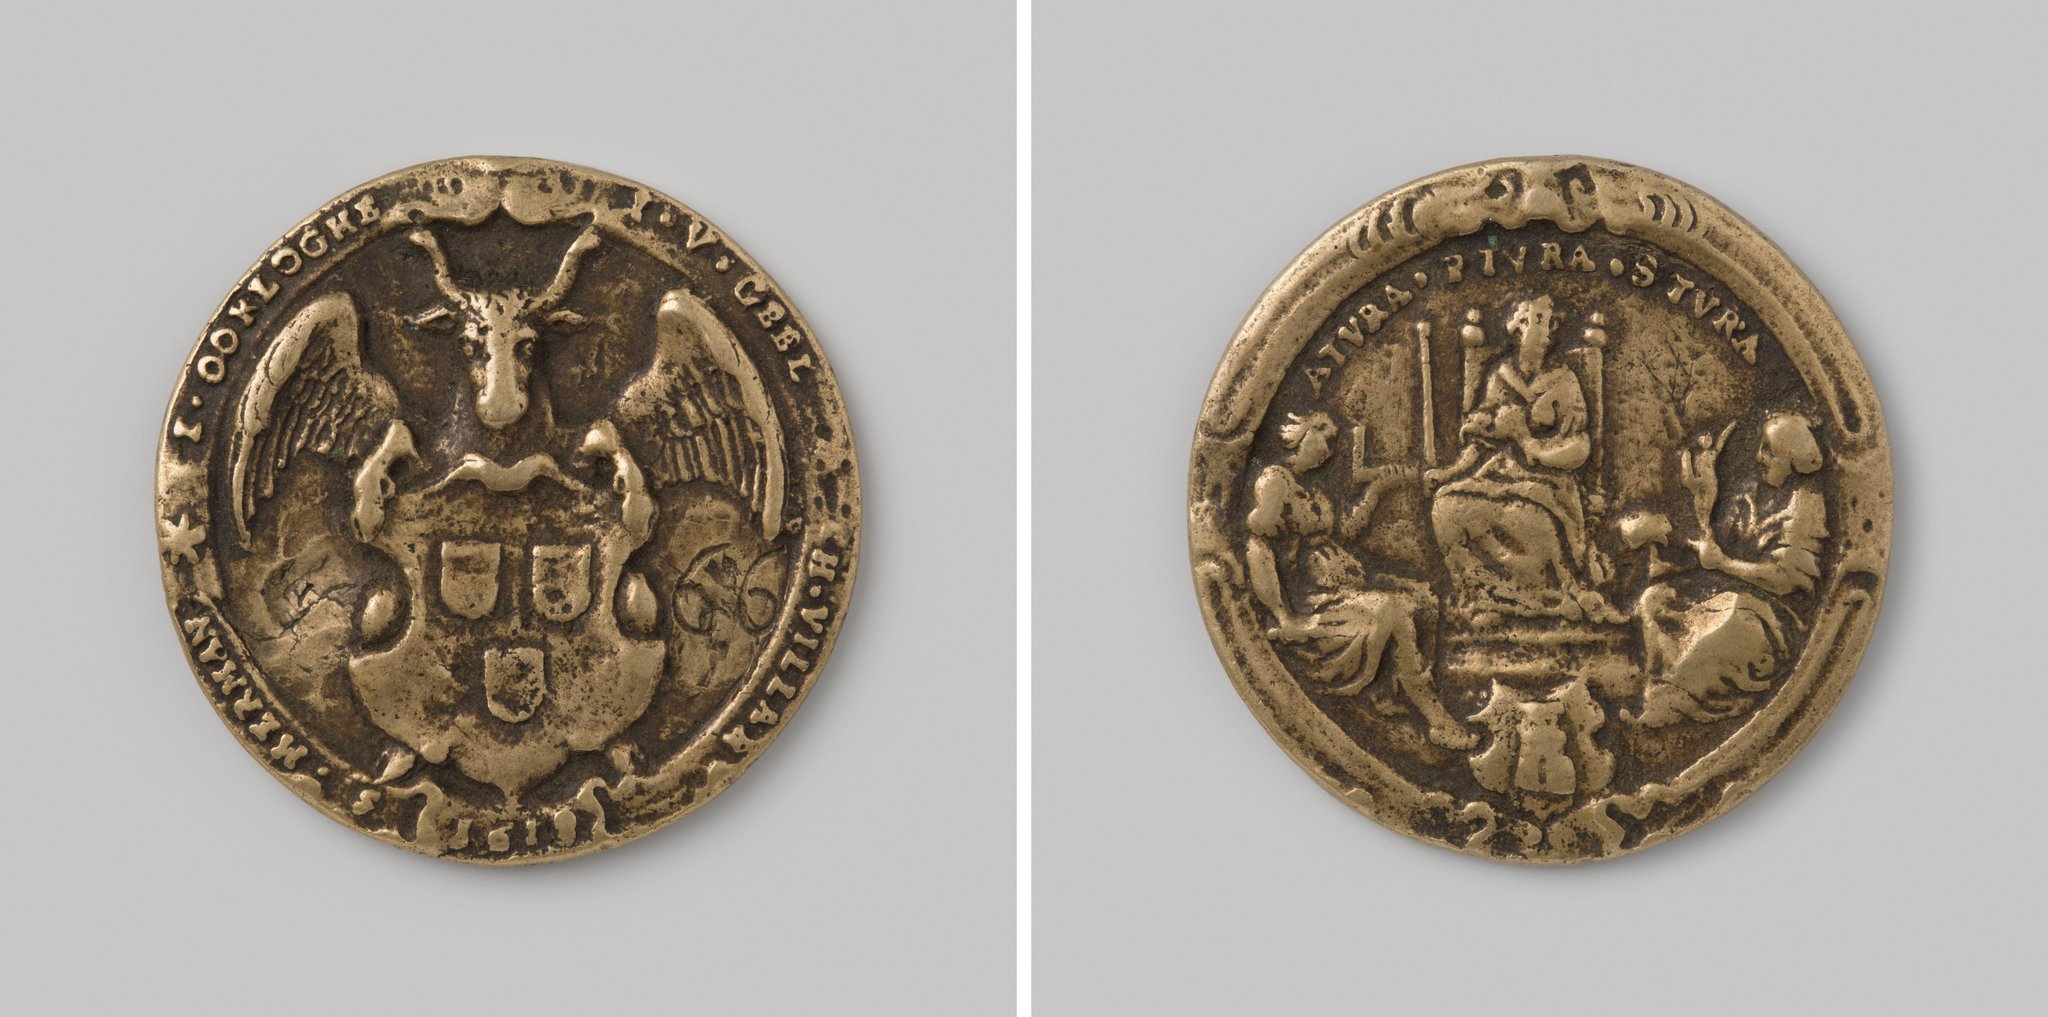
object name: medal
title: Presentiepenning van het Sint Lucas- of Schildersgilde te Middelburg, 1618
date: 1618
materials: brass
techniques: casting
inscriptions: circumscription: ‘Y V GEEL (ster) CH VILLAR - S MERMAN (ster) EI OORLOGHE’, inscription: ‘66’, inscription: ‘ATVRA PTVRA STVRA’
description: Gegoten messing penning, op de voorzijde een Lucasschild gedragen door een os boven en cartouche met 1618, met inscriptie 66 en omschrift, op de keerzijde drie personificaties: de tronende Schilderkunst tussen de Bouw- en de Beeldhouwkunst, met opschrift binnen een cirkel van banderols